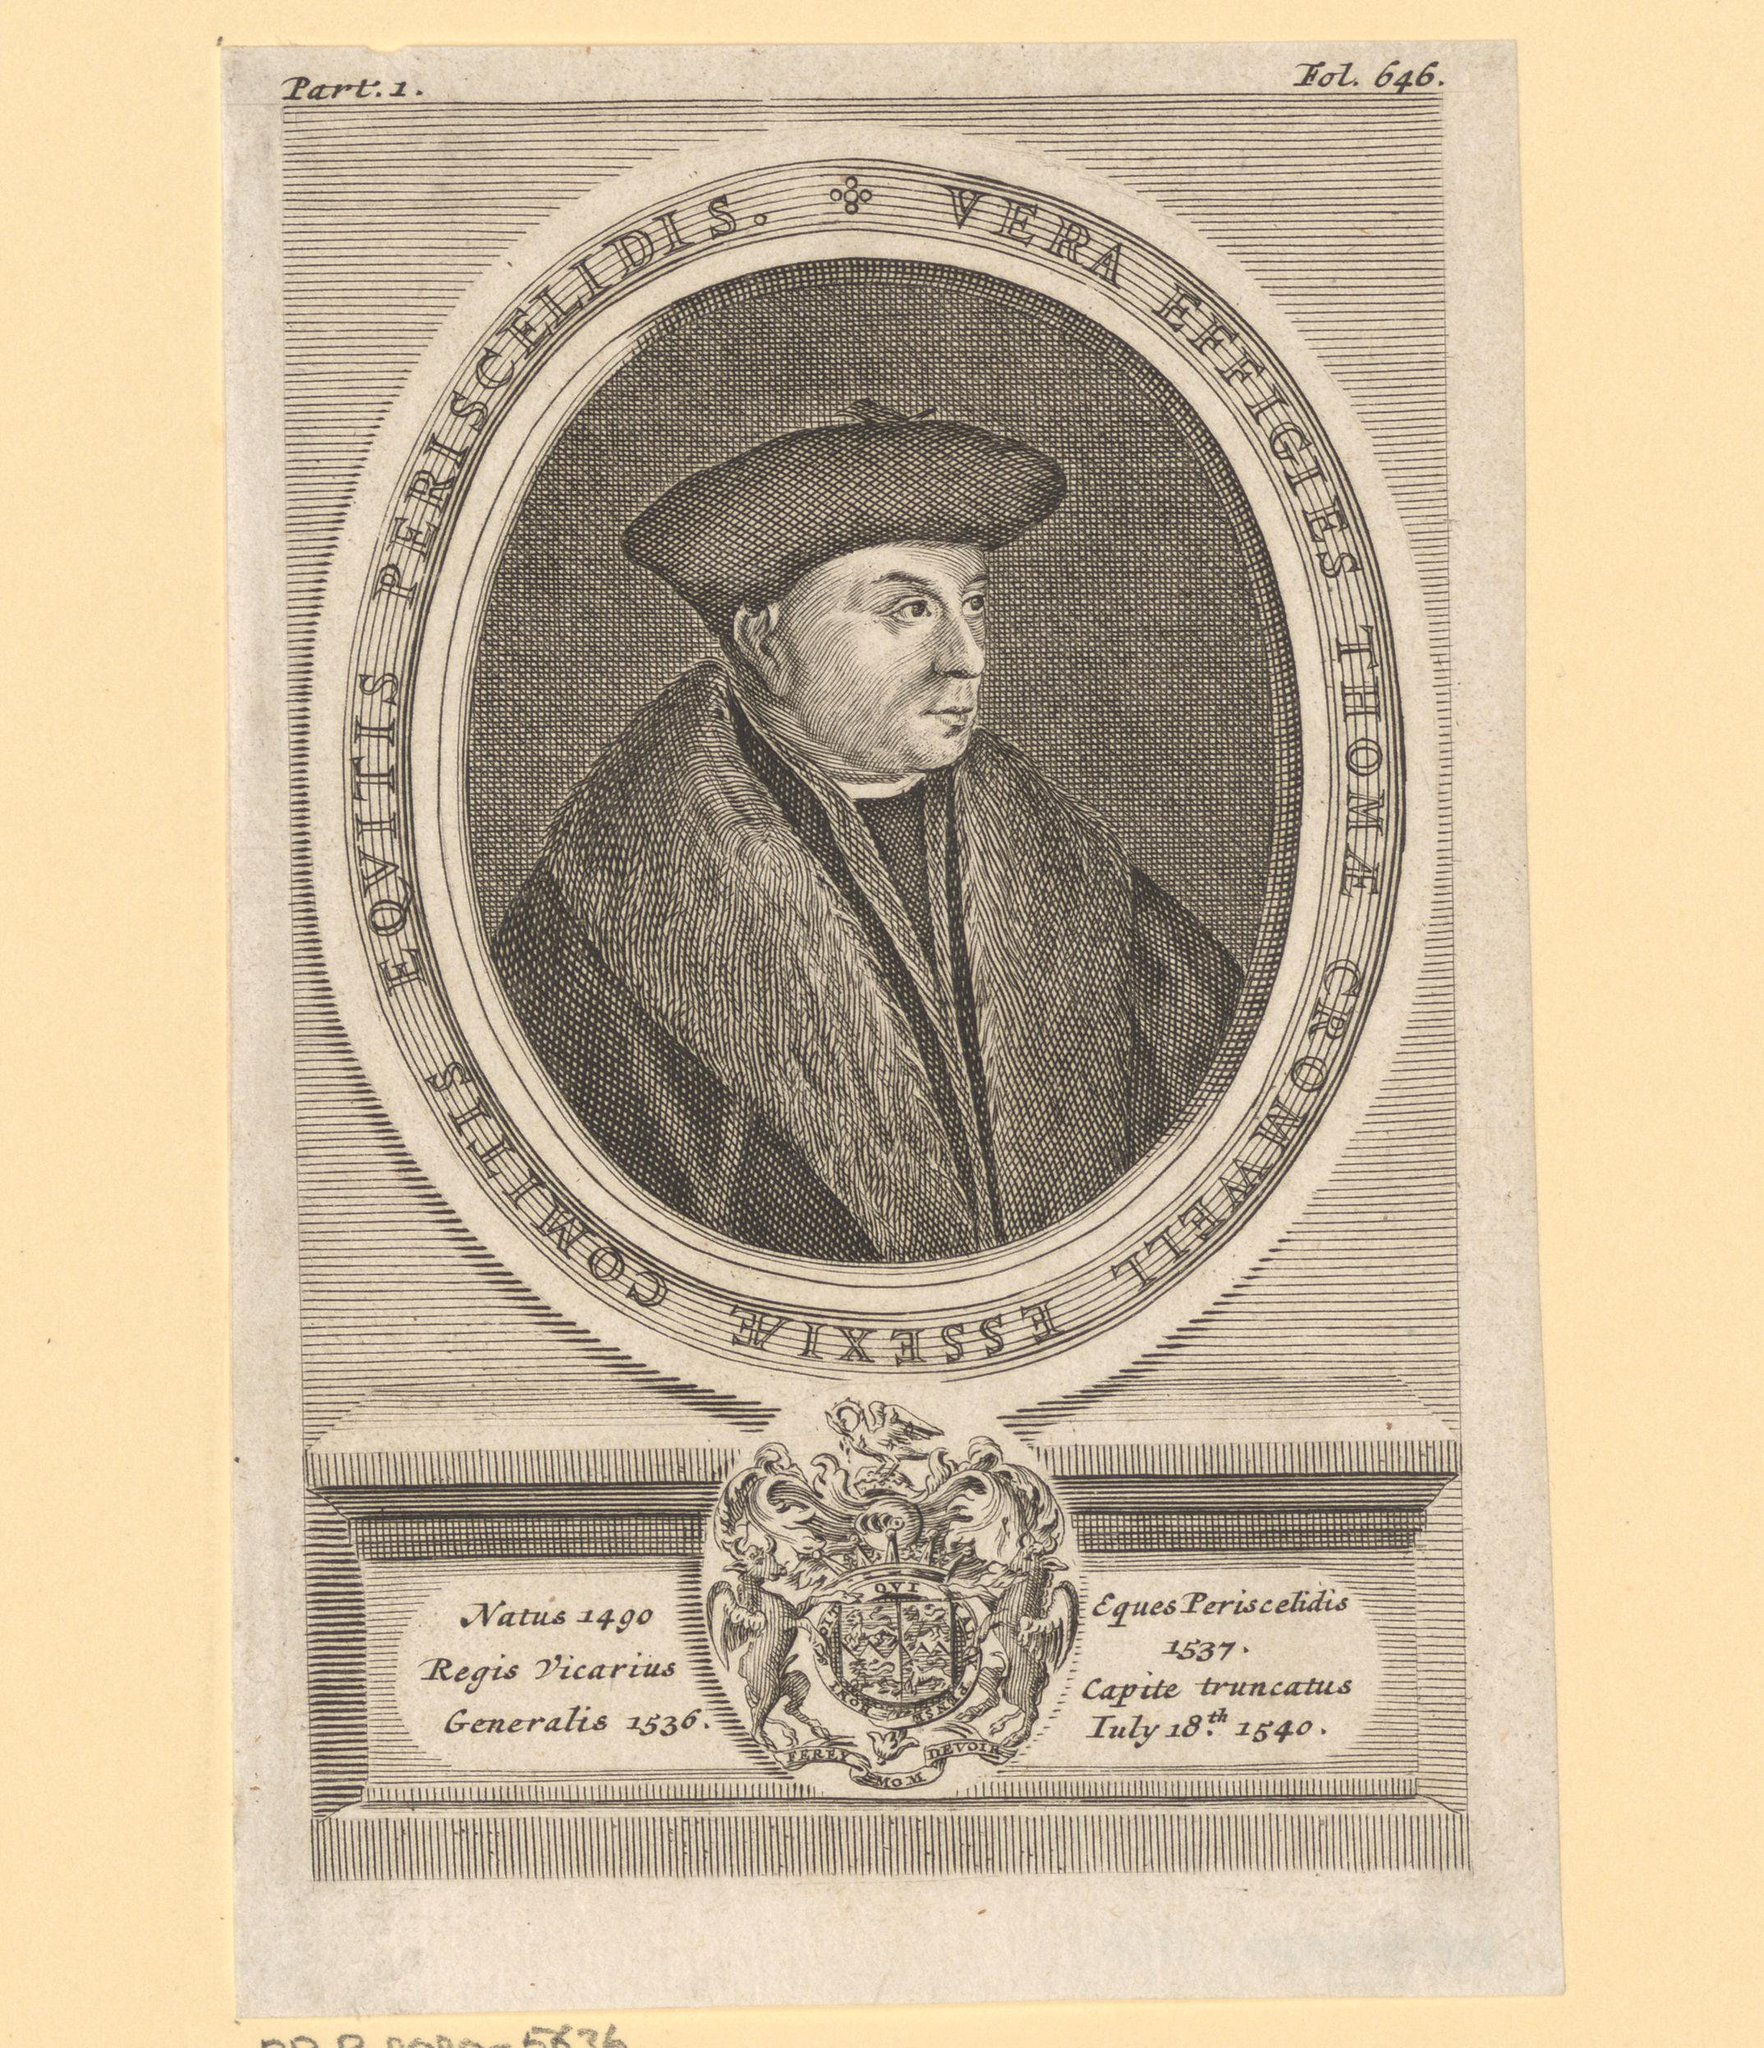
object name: print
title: Portret van Thomas Cromwell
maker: Anonymous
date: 1700-1749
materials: paper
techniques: engraving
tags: historical persons, memorial medal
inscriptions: : Lugt 2228